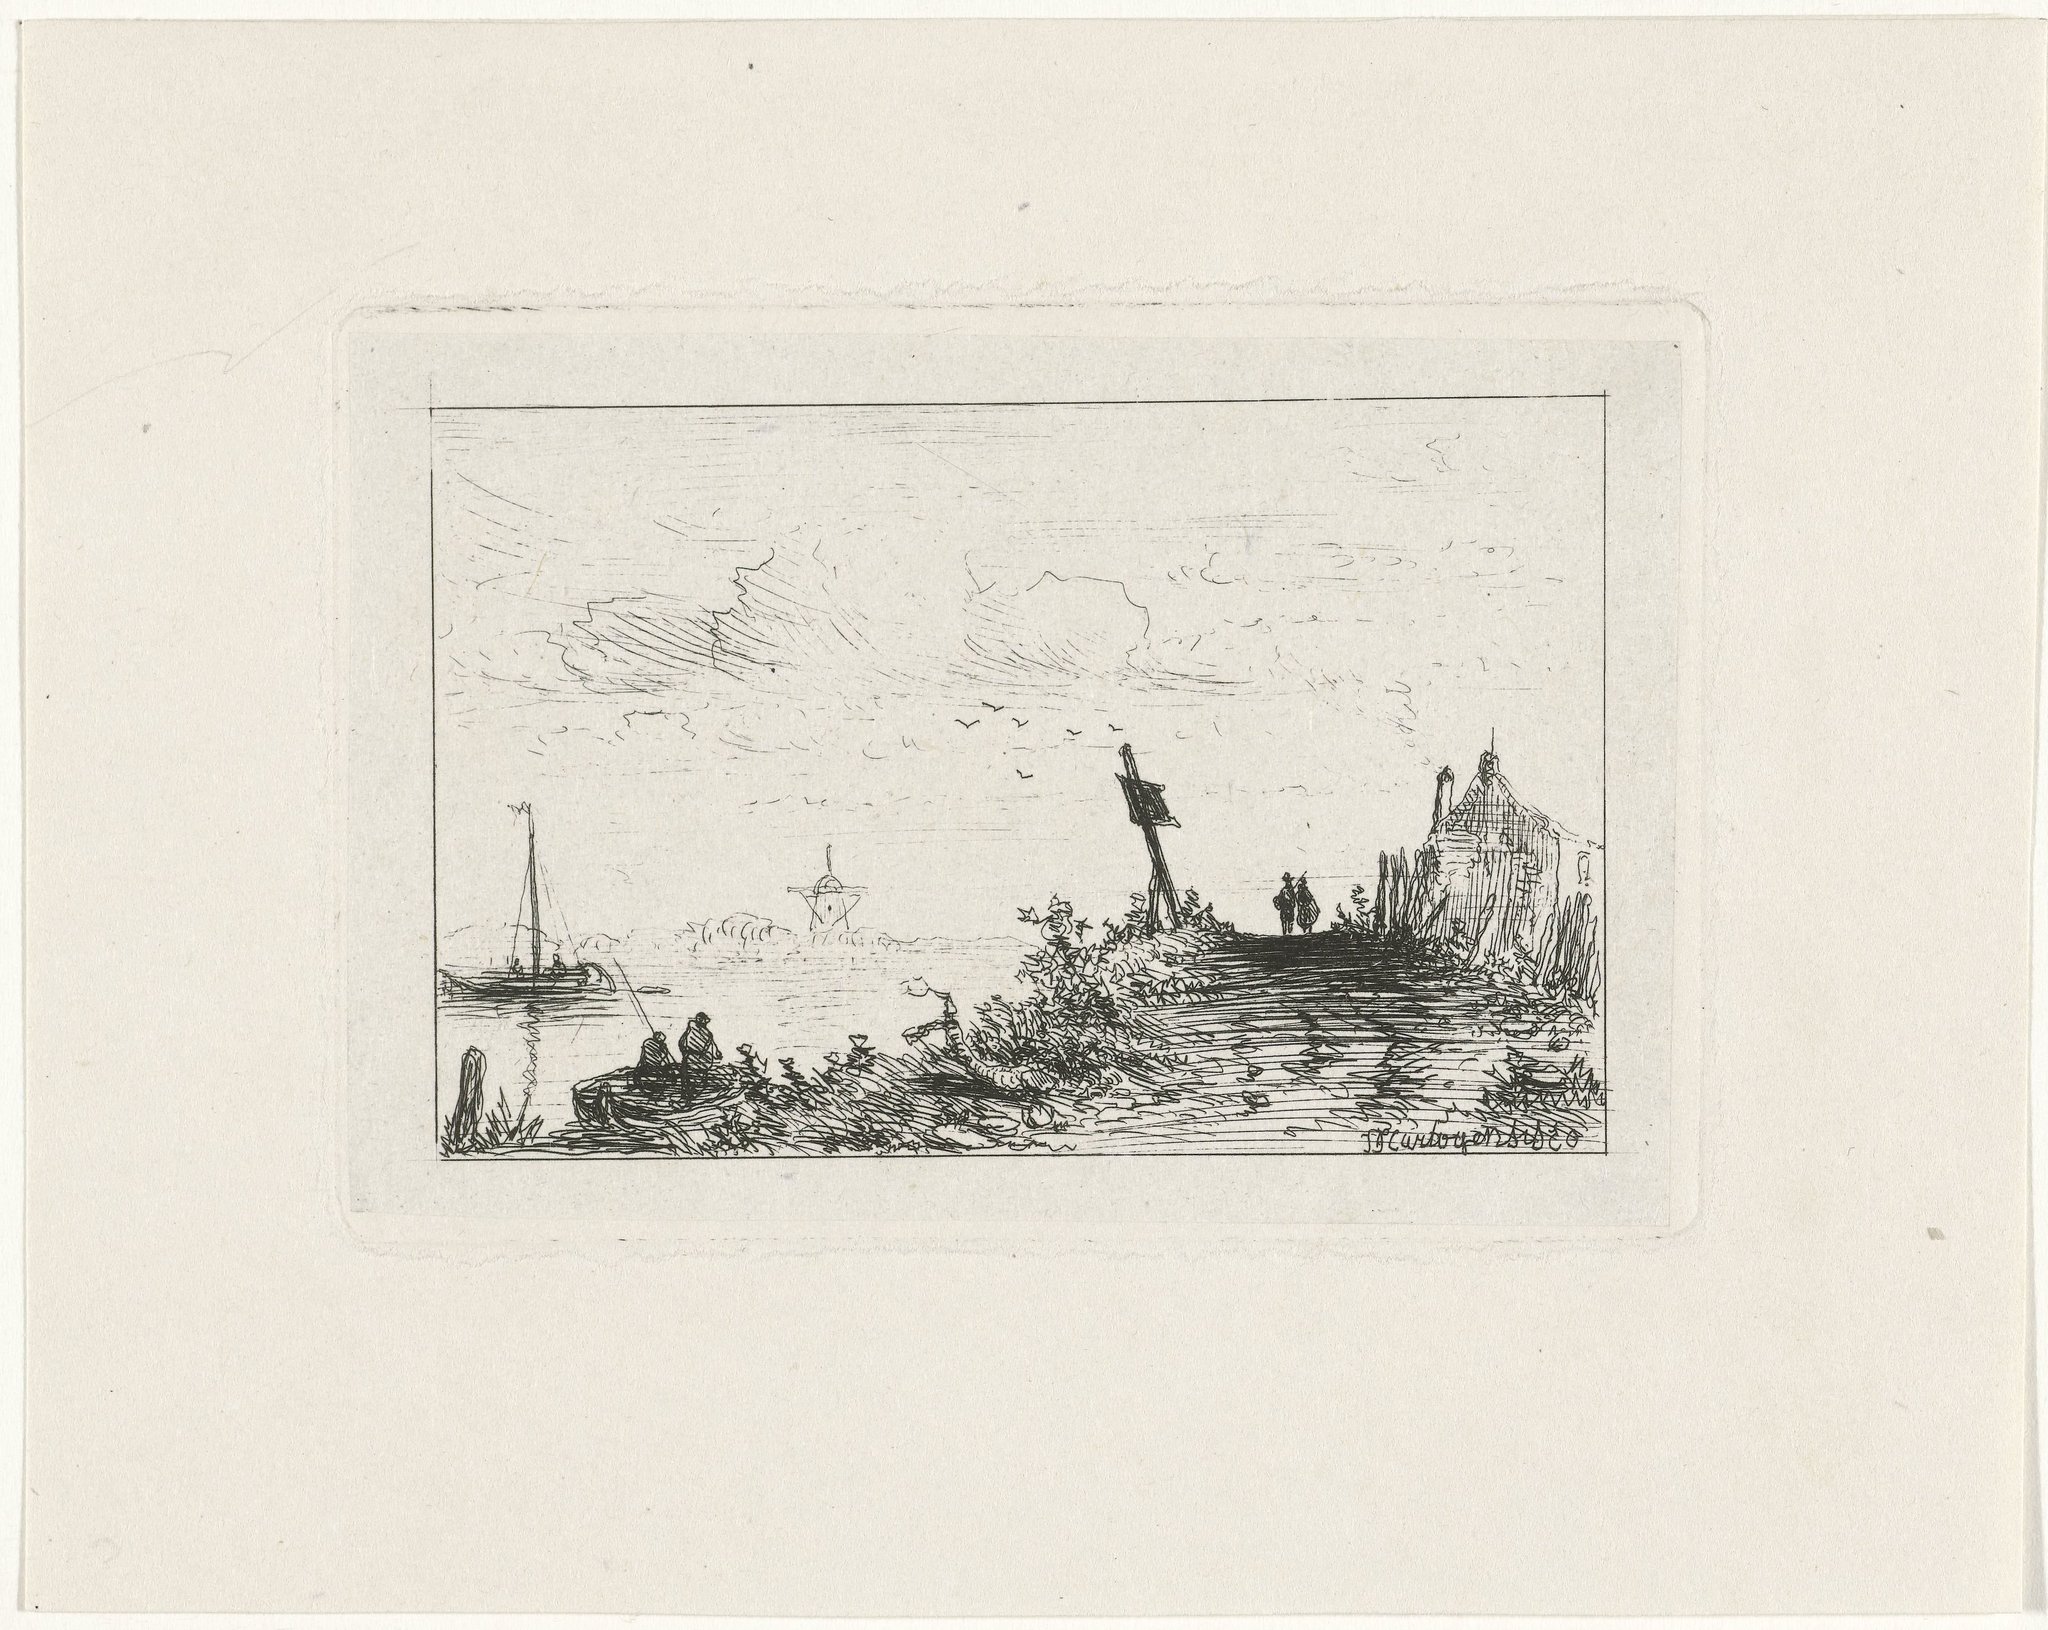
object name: print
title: Weg langs een rivier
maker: joseph hartogensis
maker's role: painter, print maker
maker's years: 1822-1865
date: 1850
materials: paper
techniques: etching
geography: dusseldorf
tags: landscapes with waters, waterscapes, seascapes (in the temperate zone) (+ landscape with figures, staffage), windmill in landscape (+ city(-scape) with figures, staffage)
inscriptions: collector's mark: Lugt 2228